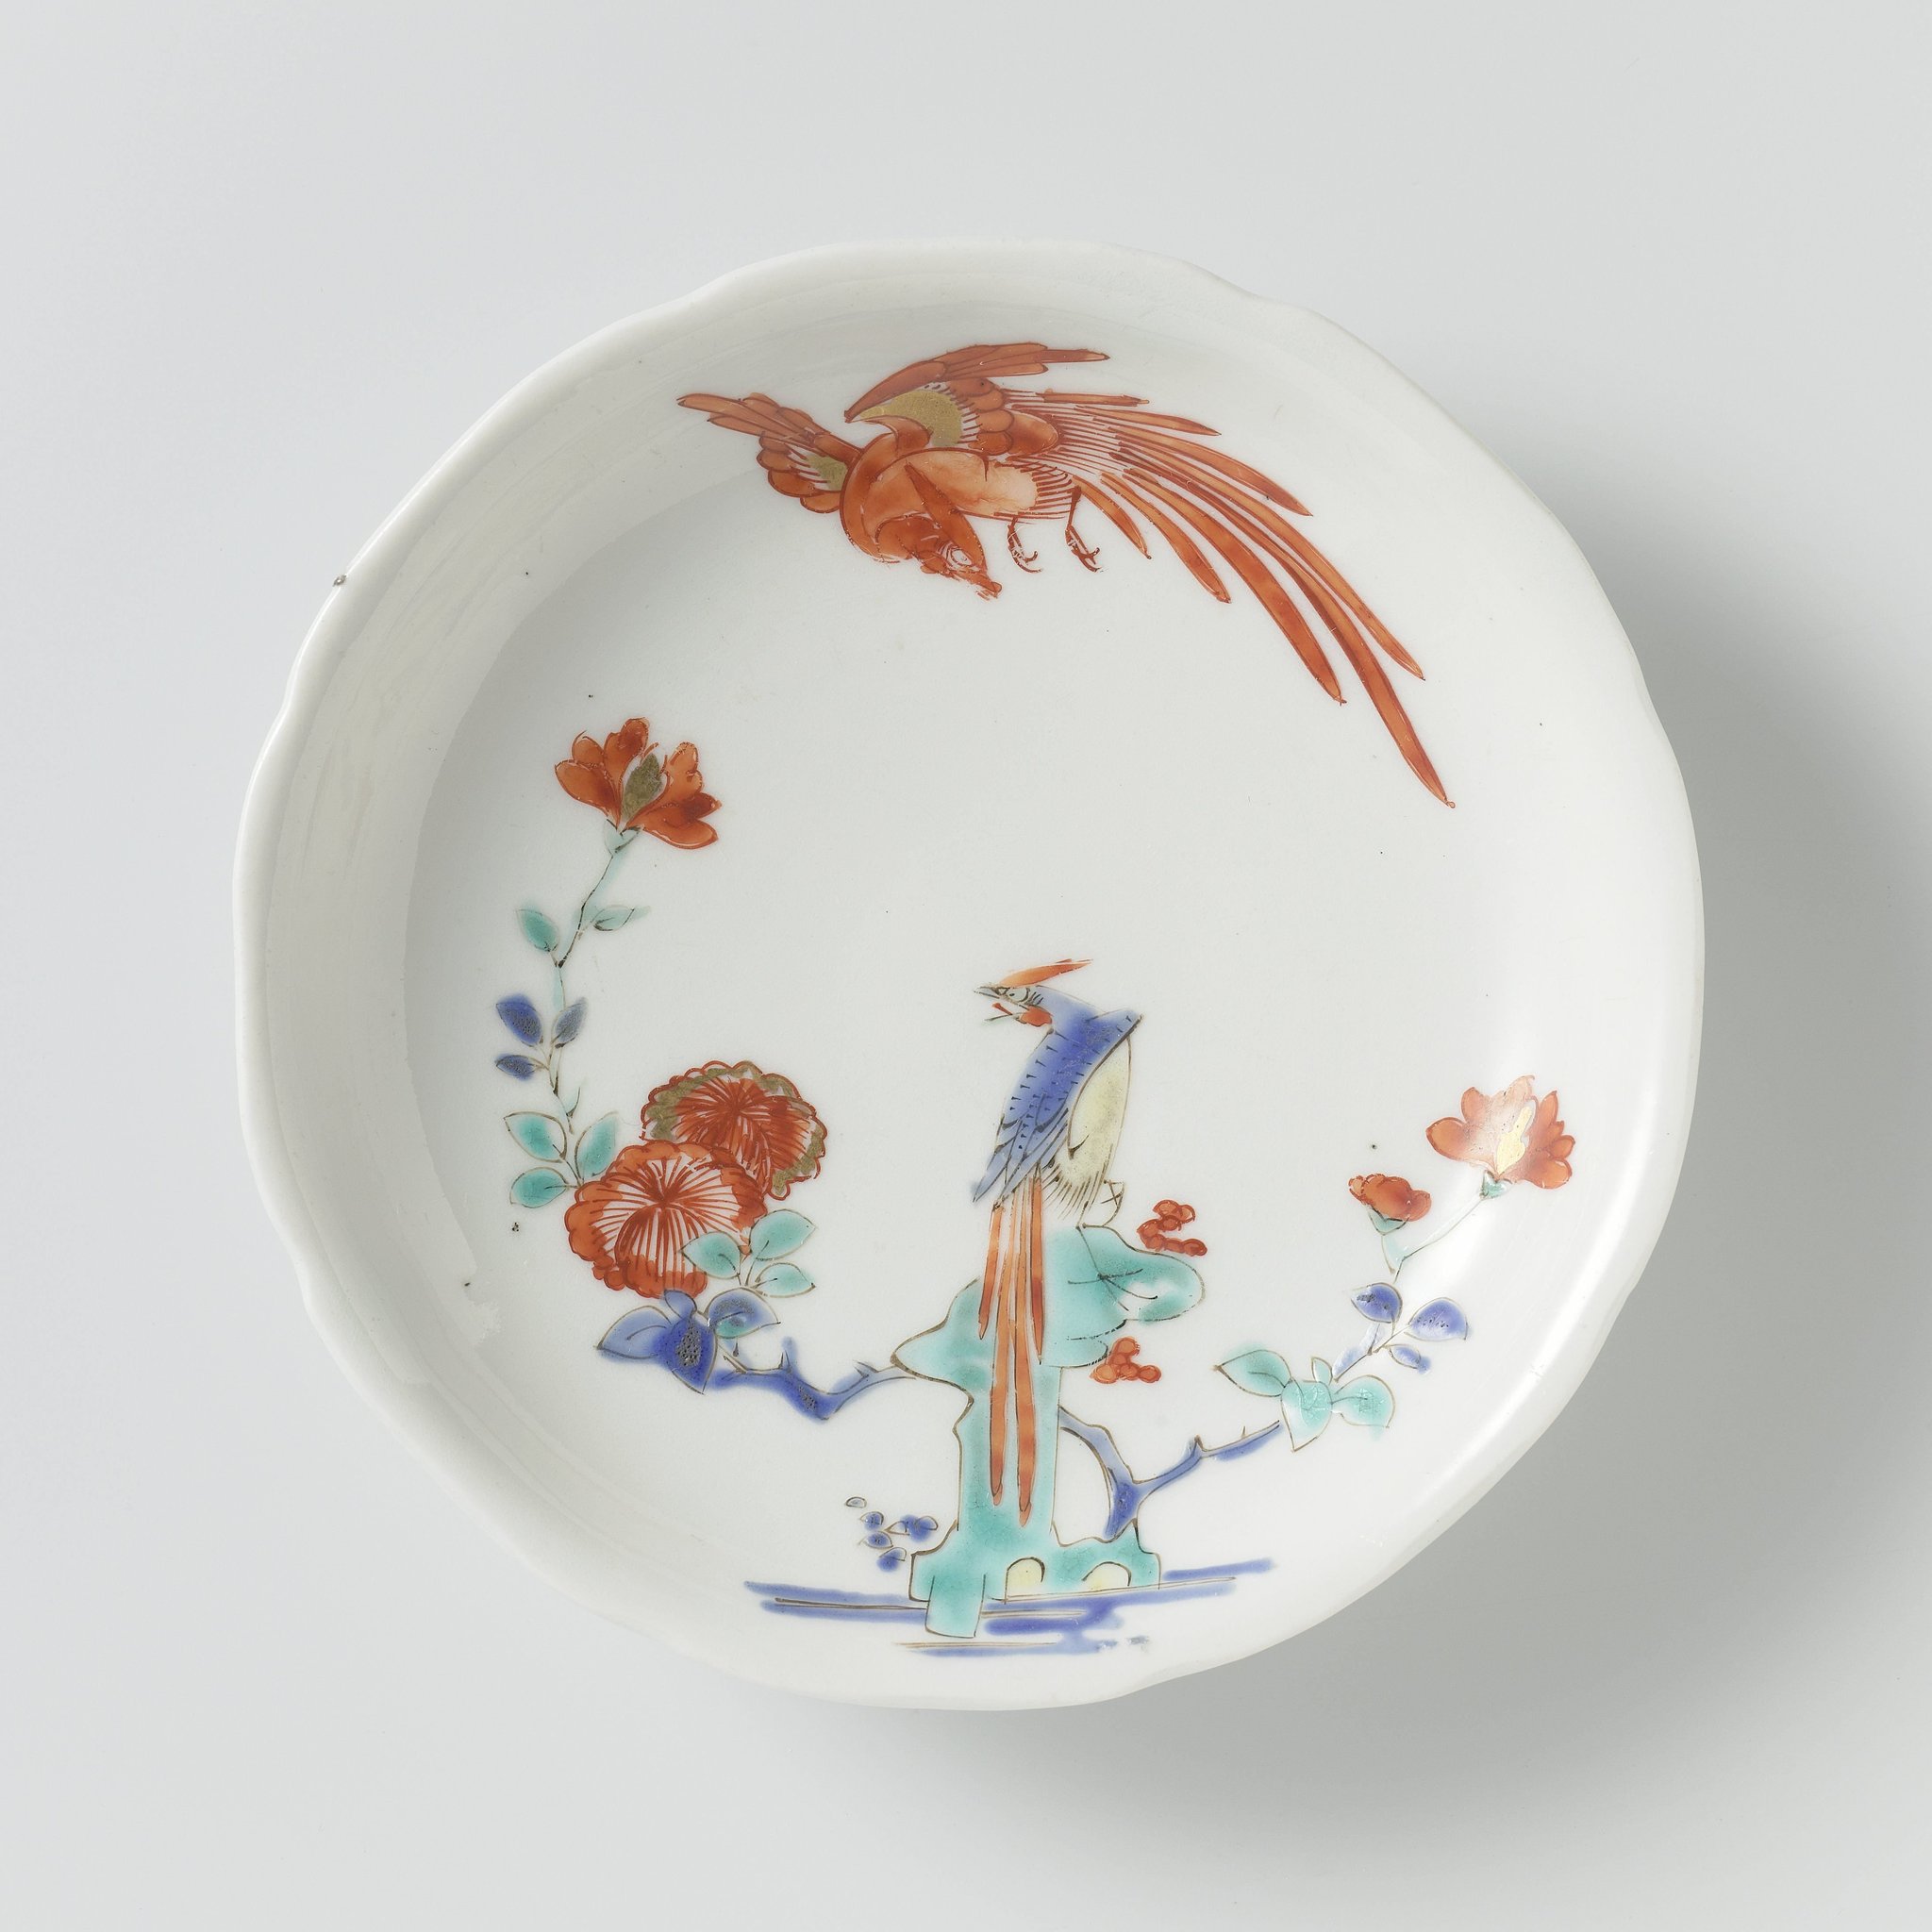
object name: platter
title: Scalloped saucer with hoo birds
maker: Anonymous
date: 1670-1700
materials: glaze, gold, paint, porcelain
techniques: firing, gilding, turning, vitrification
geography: japan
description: Geschulpte schotel van porselein, beschilderd op het glazuur in blauw, rood, groen, geel, zwart en goud met een een paar hoo-vogels, een in de lucht en een op een rots met een bloemtak. Haarlijn scheur in glazuur. Kakiemon-stijl.